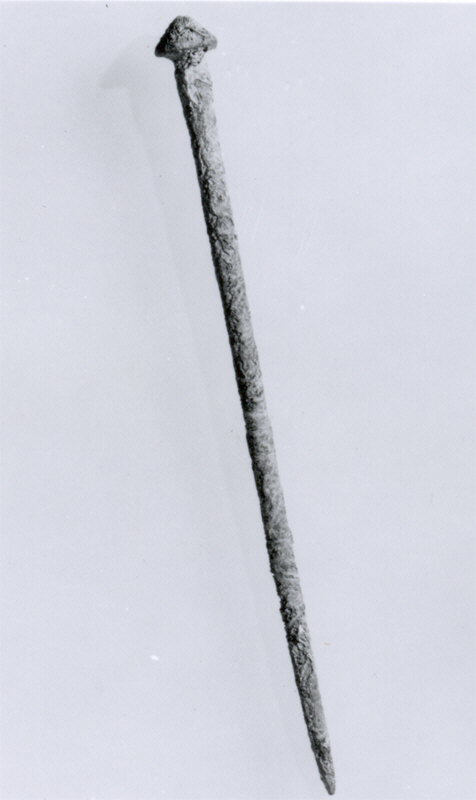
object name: pin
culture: bactria-margiana archaeological complex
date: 2333-1668 BCE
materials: copper alloy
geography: bactria-margiana